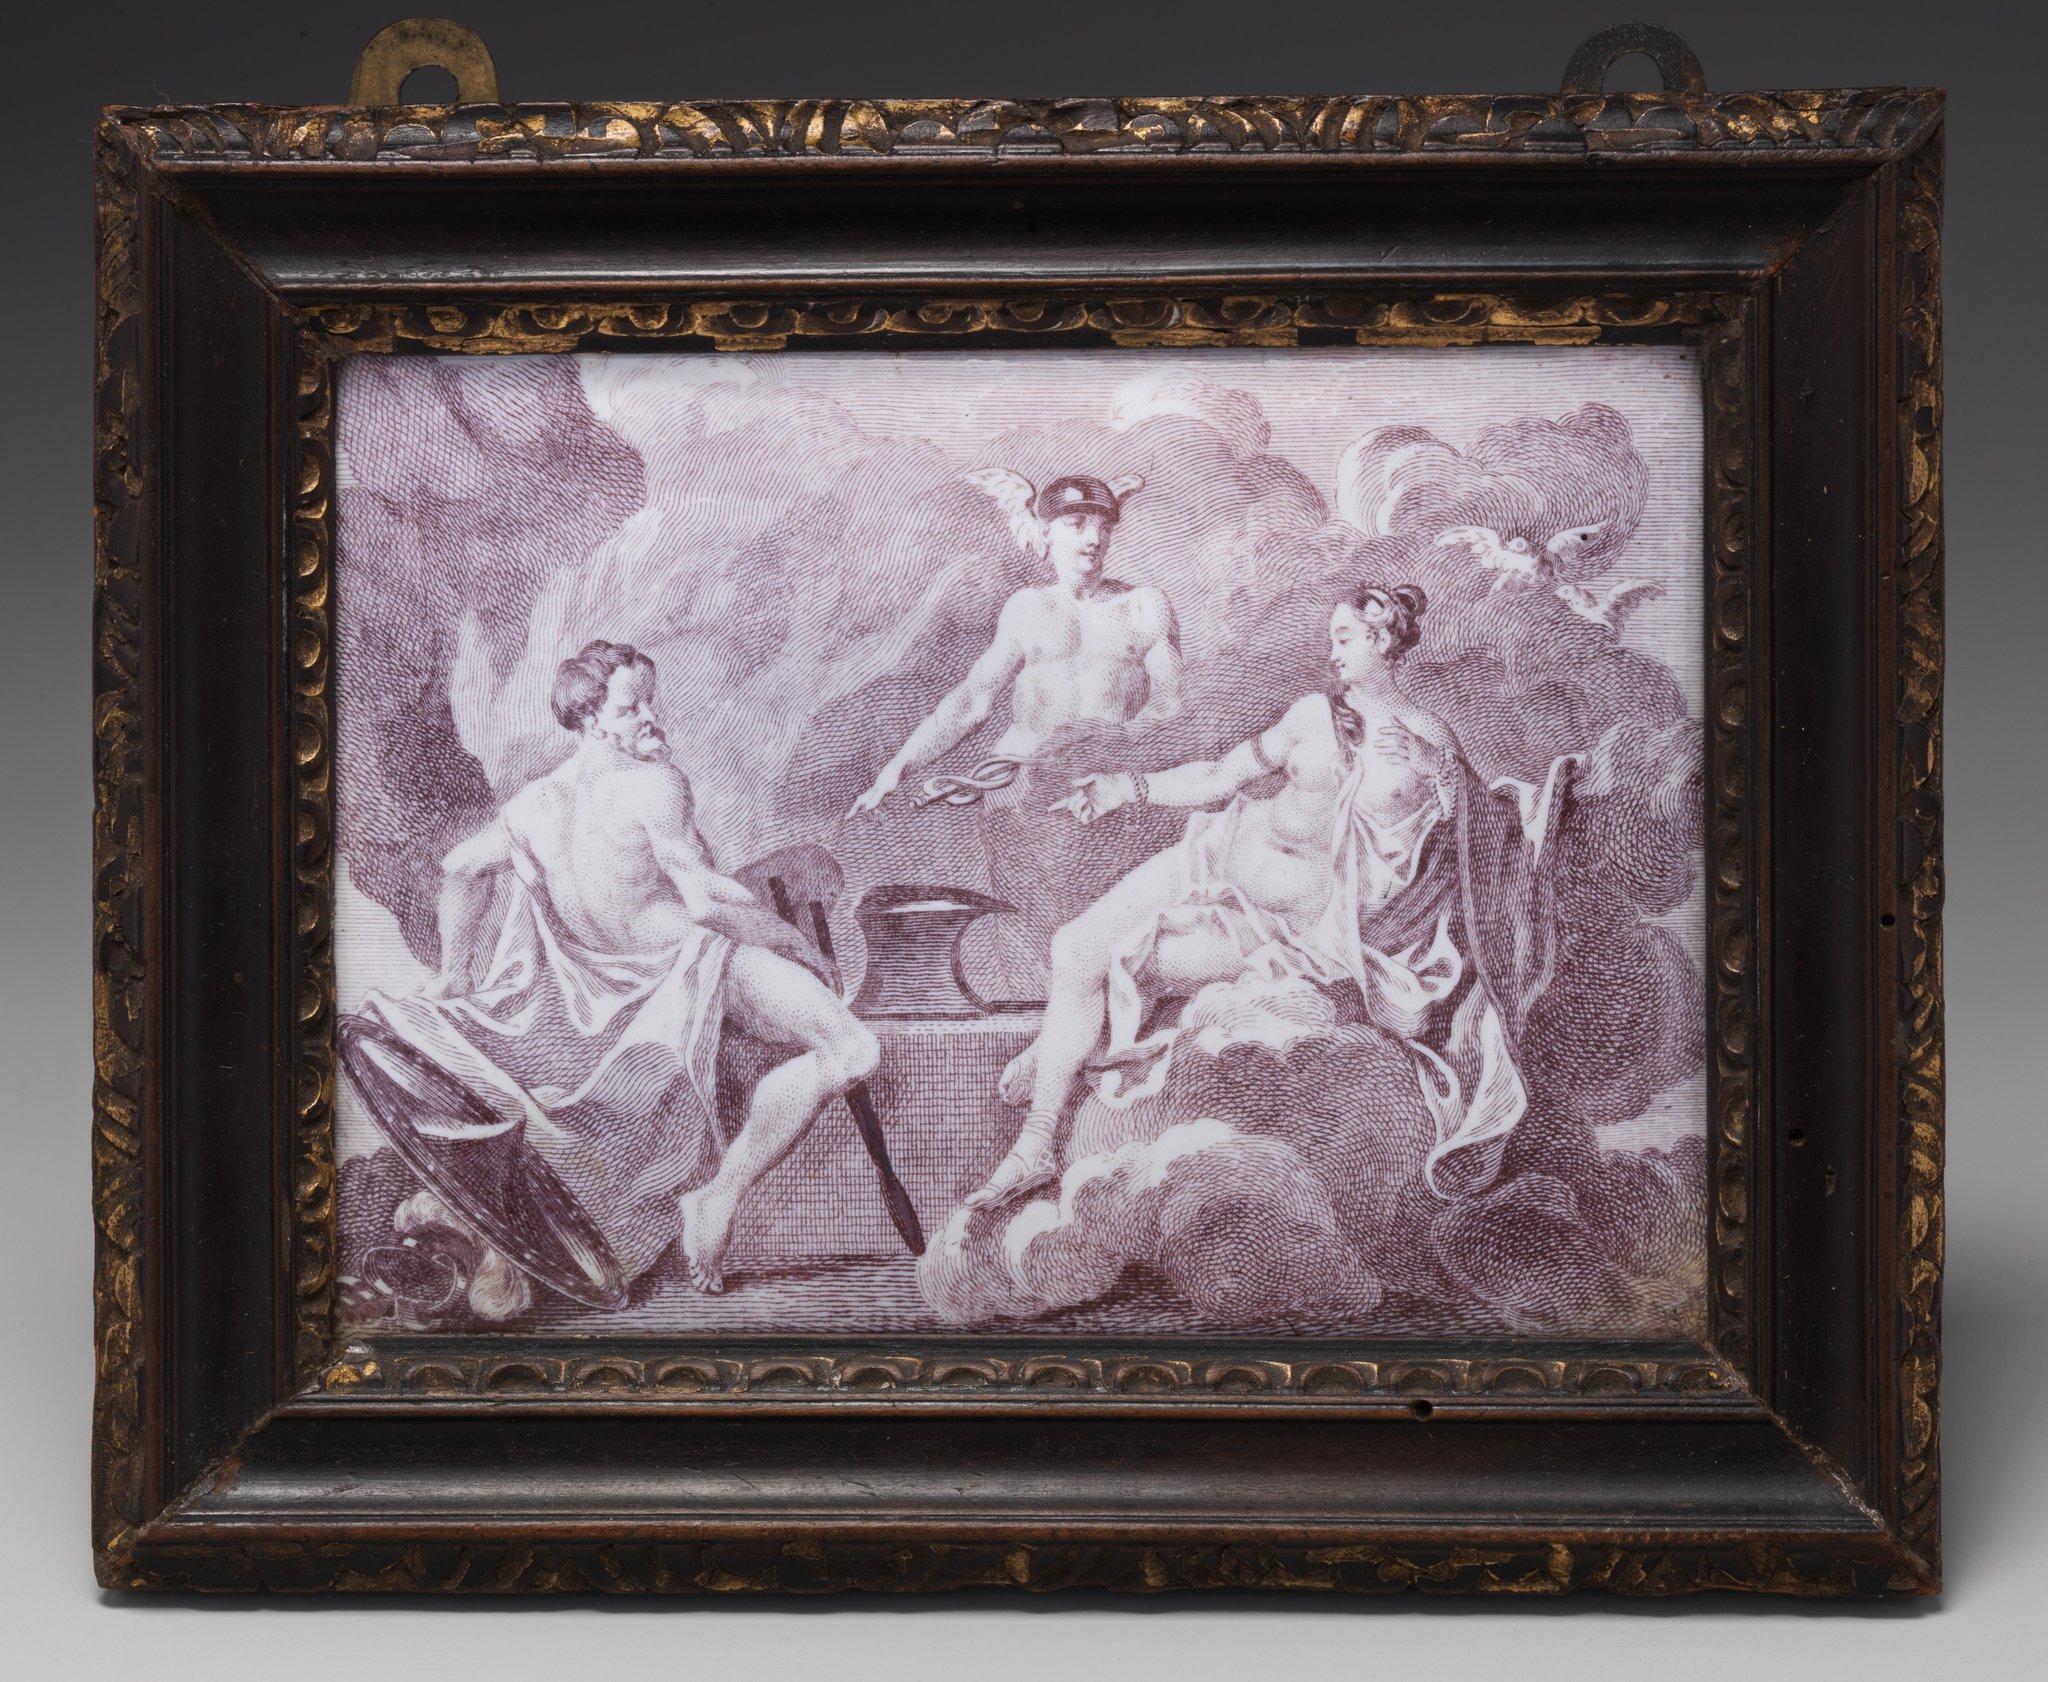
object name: plaque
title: Venus Begging Arms From Vulcan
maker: simon francis ravenet, the elder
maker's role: artist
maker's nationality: french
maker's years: 1706-1774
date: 1753-1756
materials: copper, enamel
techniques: transfer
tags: female nudes,venus,vulcan